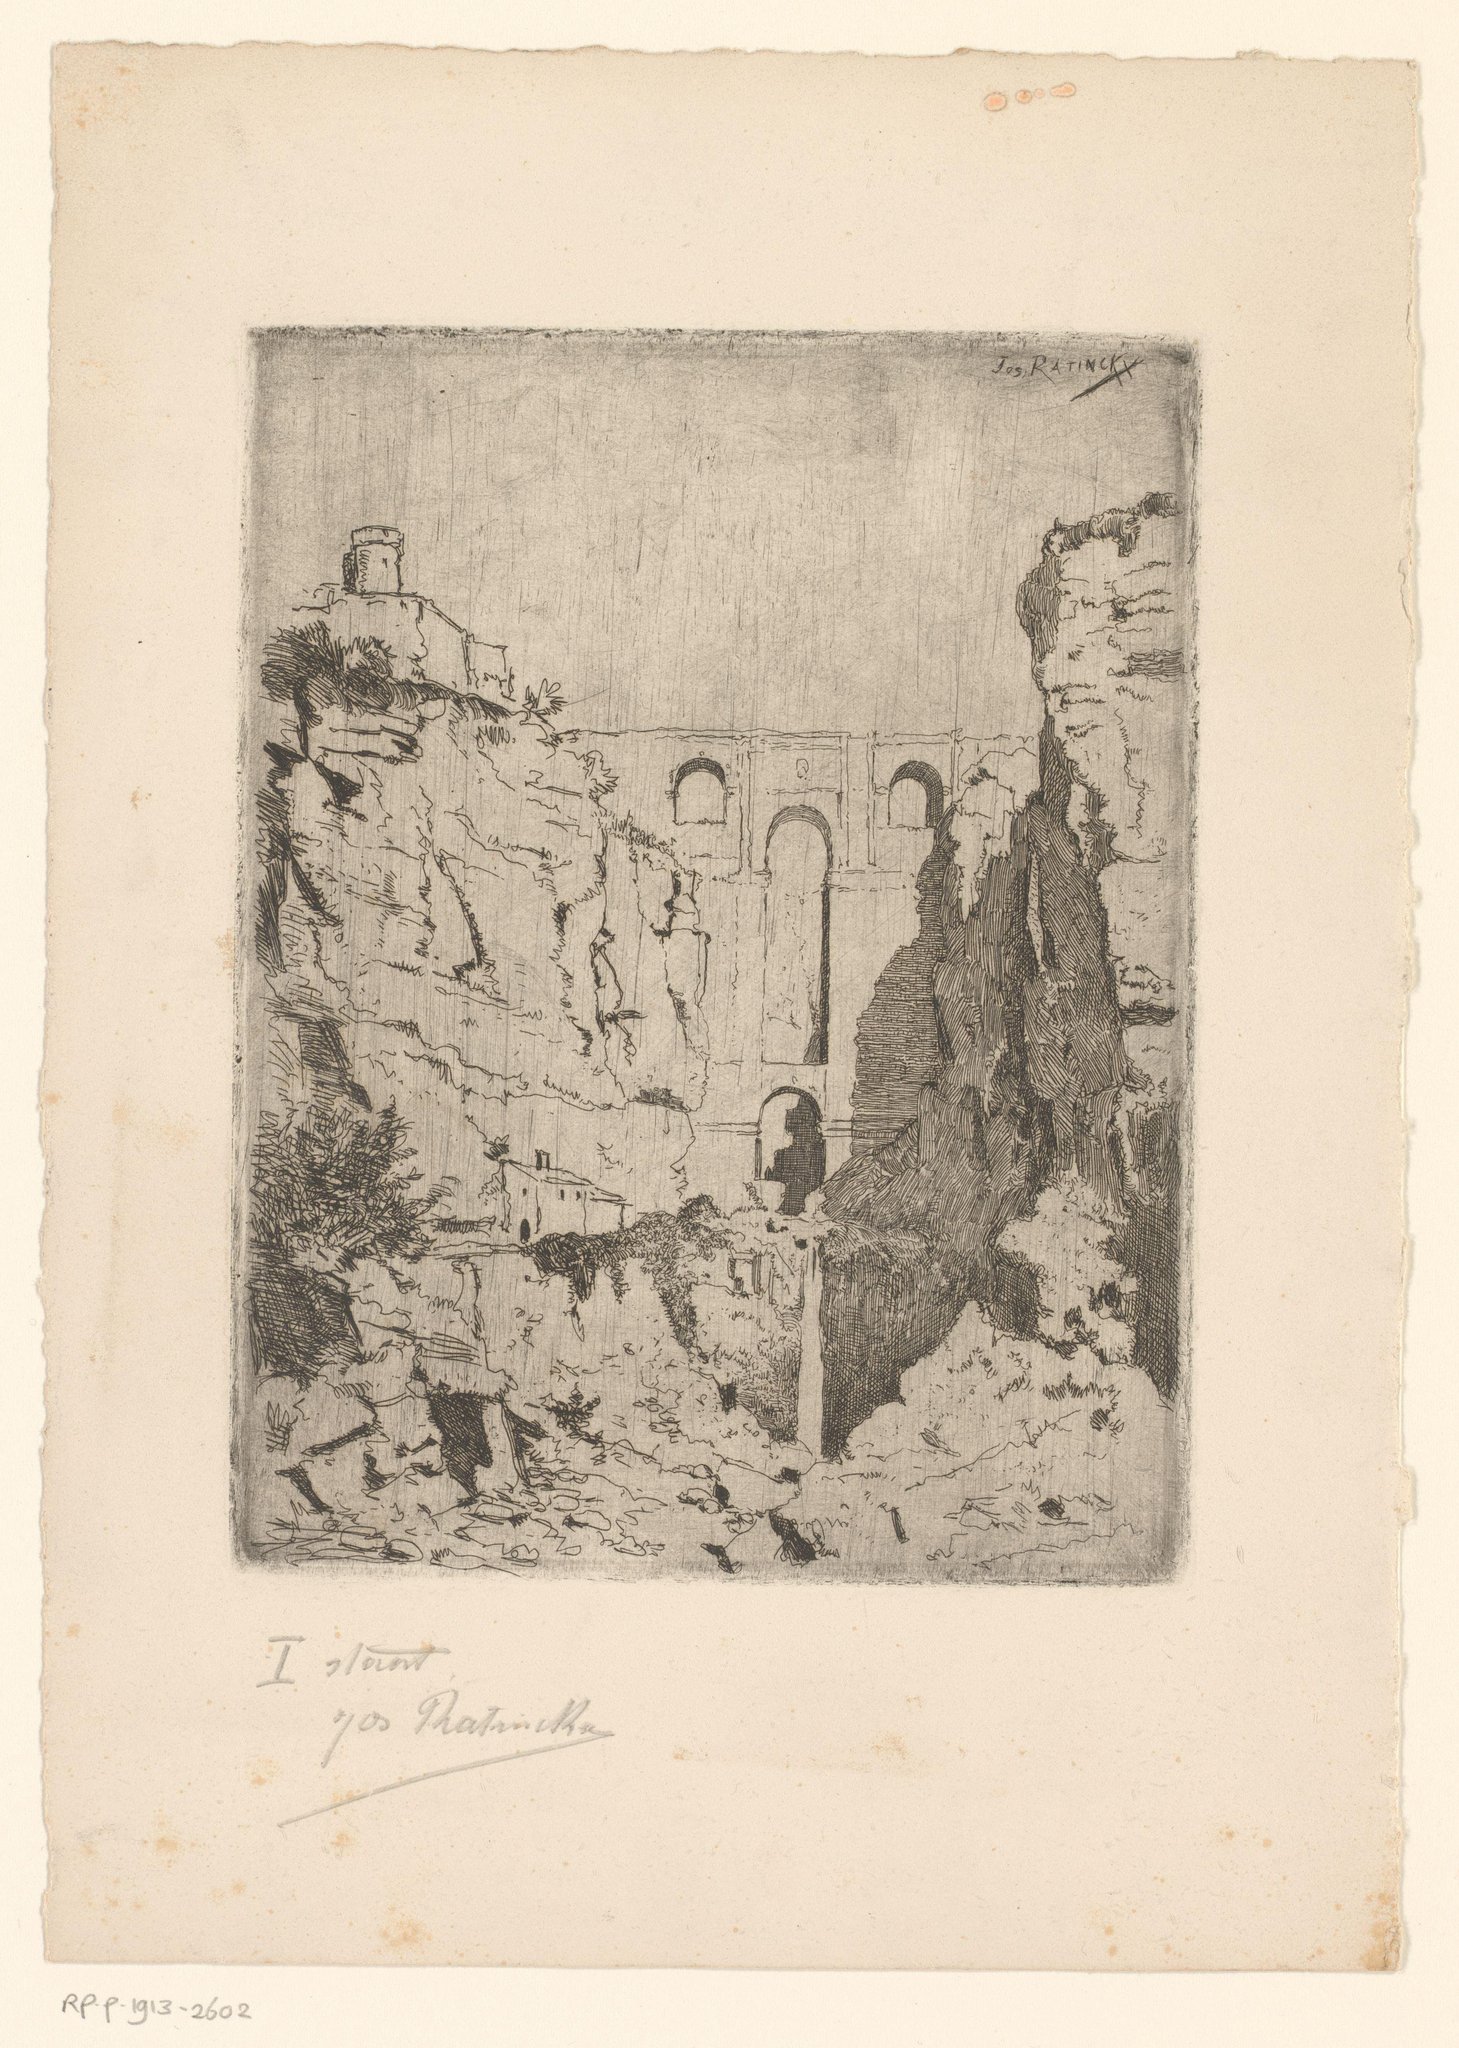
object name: print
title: Berglandschap met een ruïne in een kloof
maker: jos ratinckx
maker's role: print maker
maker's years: 1860-1937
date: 1870-1913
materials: paper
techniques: etching, intaglio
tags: landscape with bridge, viaduct or aqueduct, ravine, chasm, abyss, canyon, landscape with ruins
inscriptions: inscription: ‘I staat’, collector's mark: Lugt 2228